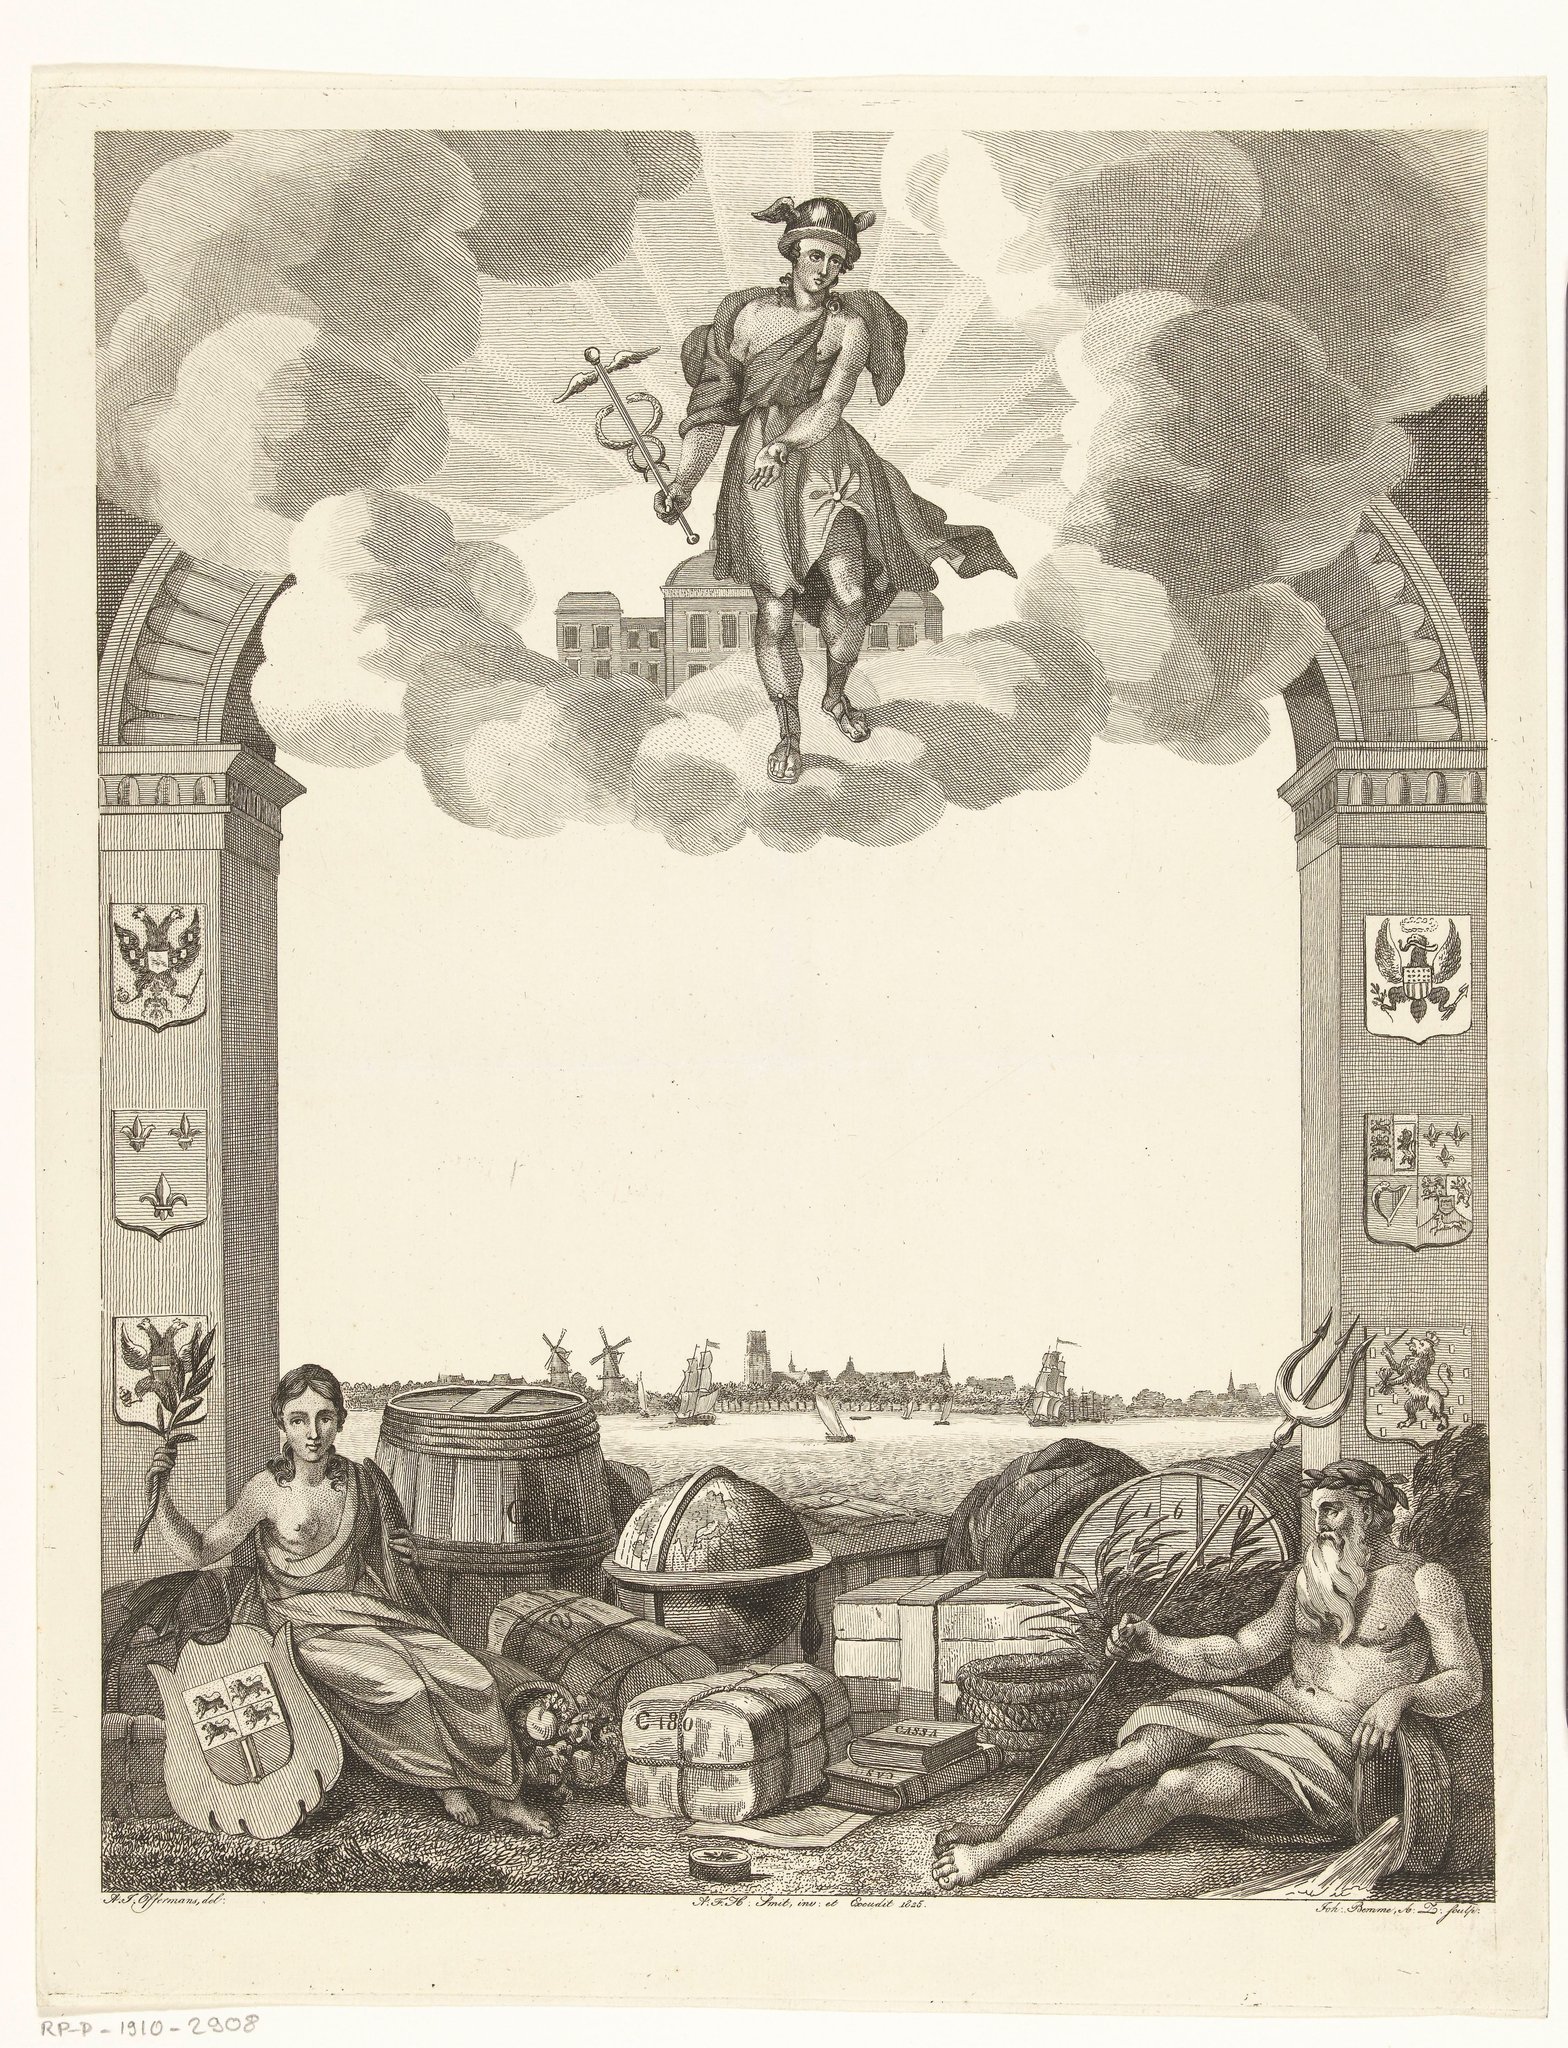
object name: print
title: Gezicht op een stad aan het water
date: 1825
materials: paper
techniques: etching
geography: rotterdam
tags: (story of) neptune (poseidon), symbols, allegories of peace, 'pax'; 'pace' (ripa), city-view in general; 'veduta', (story of) mercury (hermes)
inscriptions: collector's mark: Lugt 2228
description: Door een portaal is een stadsgezicht aan het water te zien. Op de voorgrond allerlei handelswaar, zoals vaten, pakketten en kisten. Rechts zit Neptunus en links de Vrede. In de hemel, op een wolk staande, Mercurius voor een huis. Op het portaal zes wapenschilden.